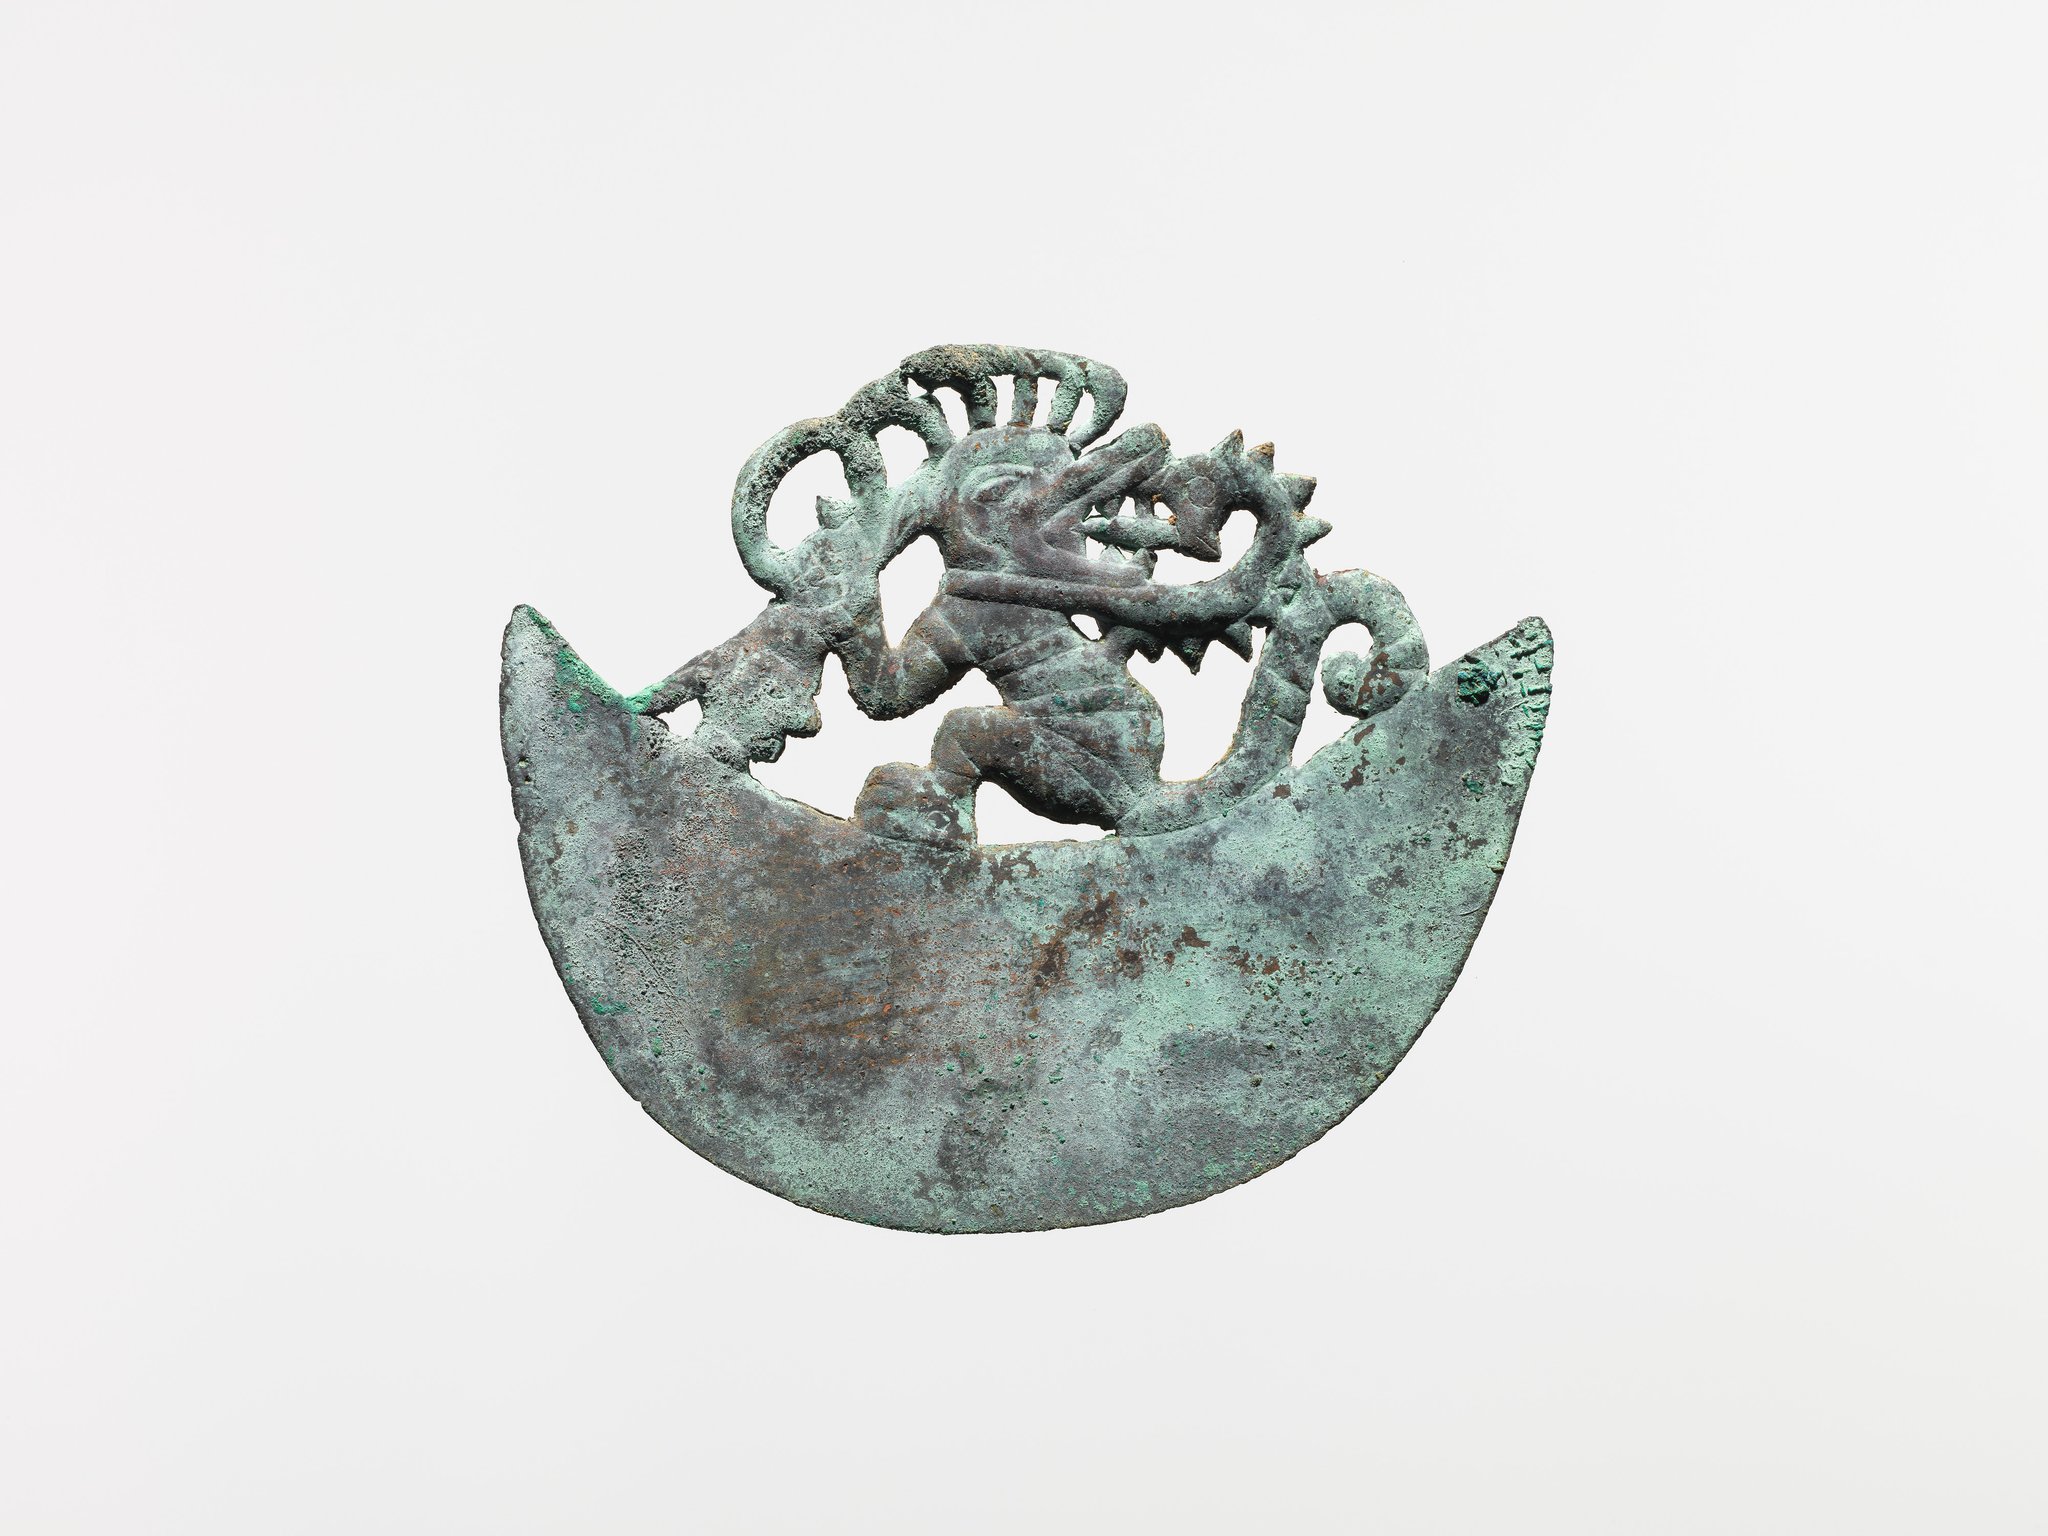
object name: ornament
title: Crescent Ornament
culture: moche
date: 501-700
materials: gilt copper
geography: peru